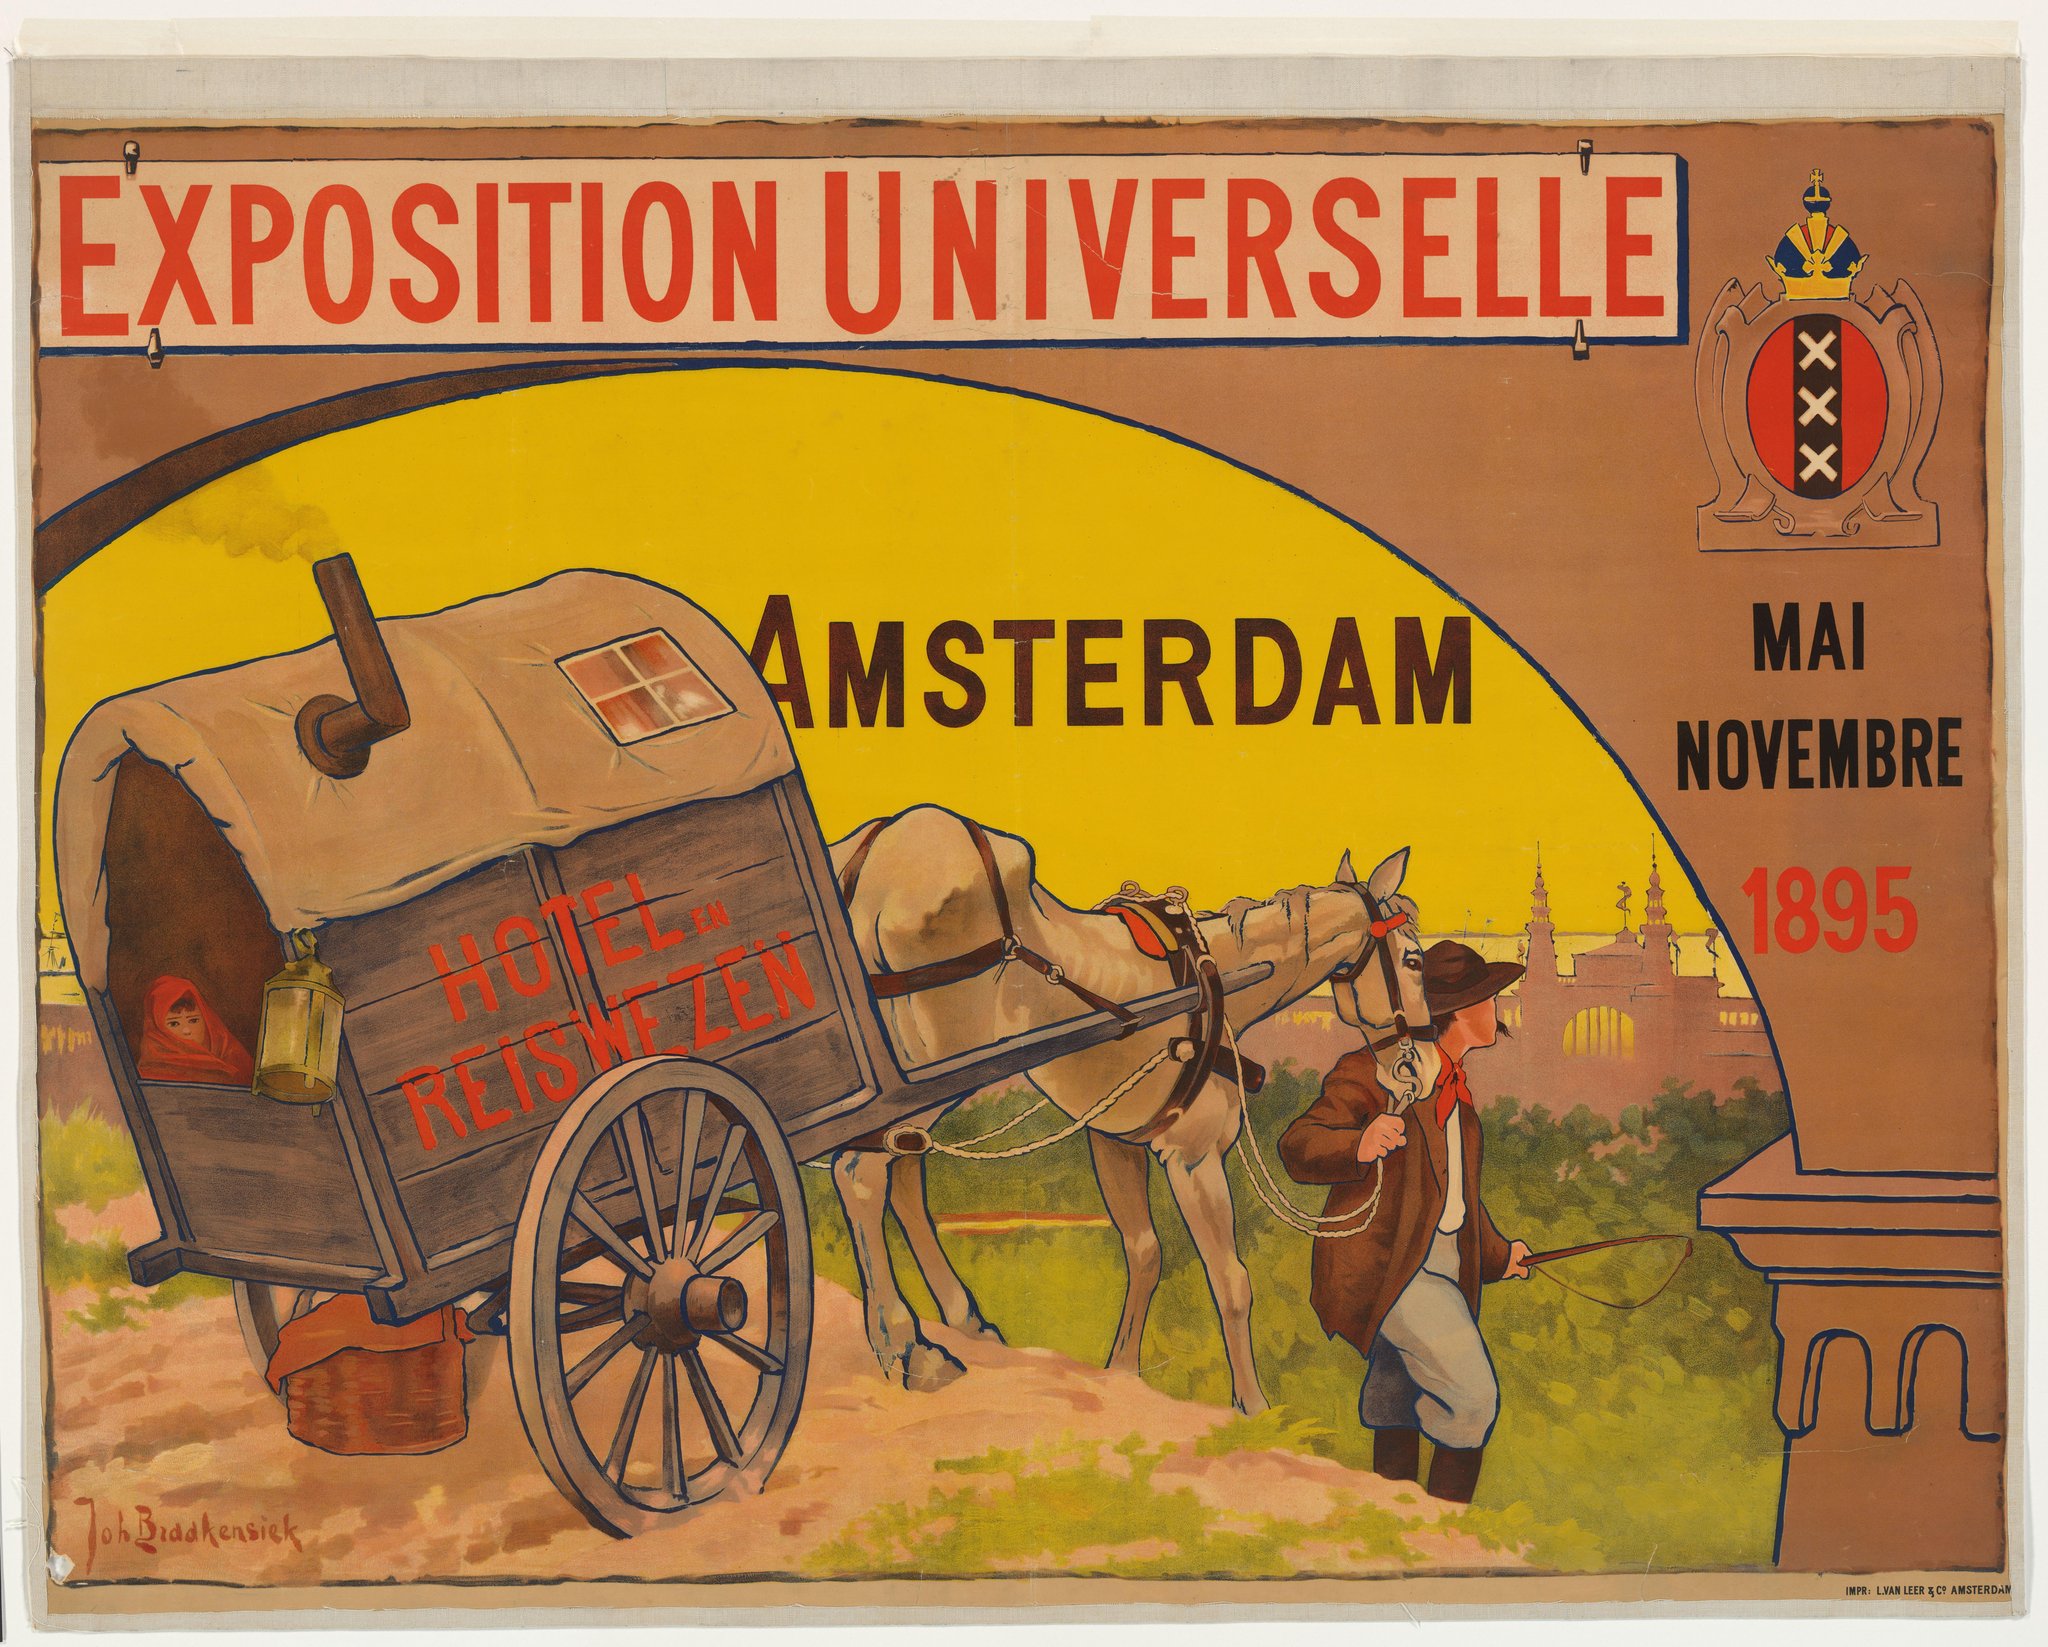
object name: print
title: Affiche voor de Wereldtentoonstelling voor het Hotel- en Reiswezen te Amsterdam, 1895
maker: johan braakensiek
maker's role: draughtsman, print maker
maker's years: 1858-1940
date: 1895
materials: paper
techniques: lithograph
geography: amsterdam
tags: device (as symbol of the state, etc.) (+ city; municipal), world fair, world exhibition, two-wheeled vehicle drawn by one animal, amsterdam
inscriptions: collector's mark: Lugt 2166